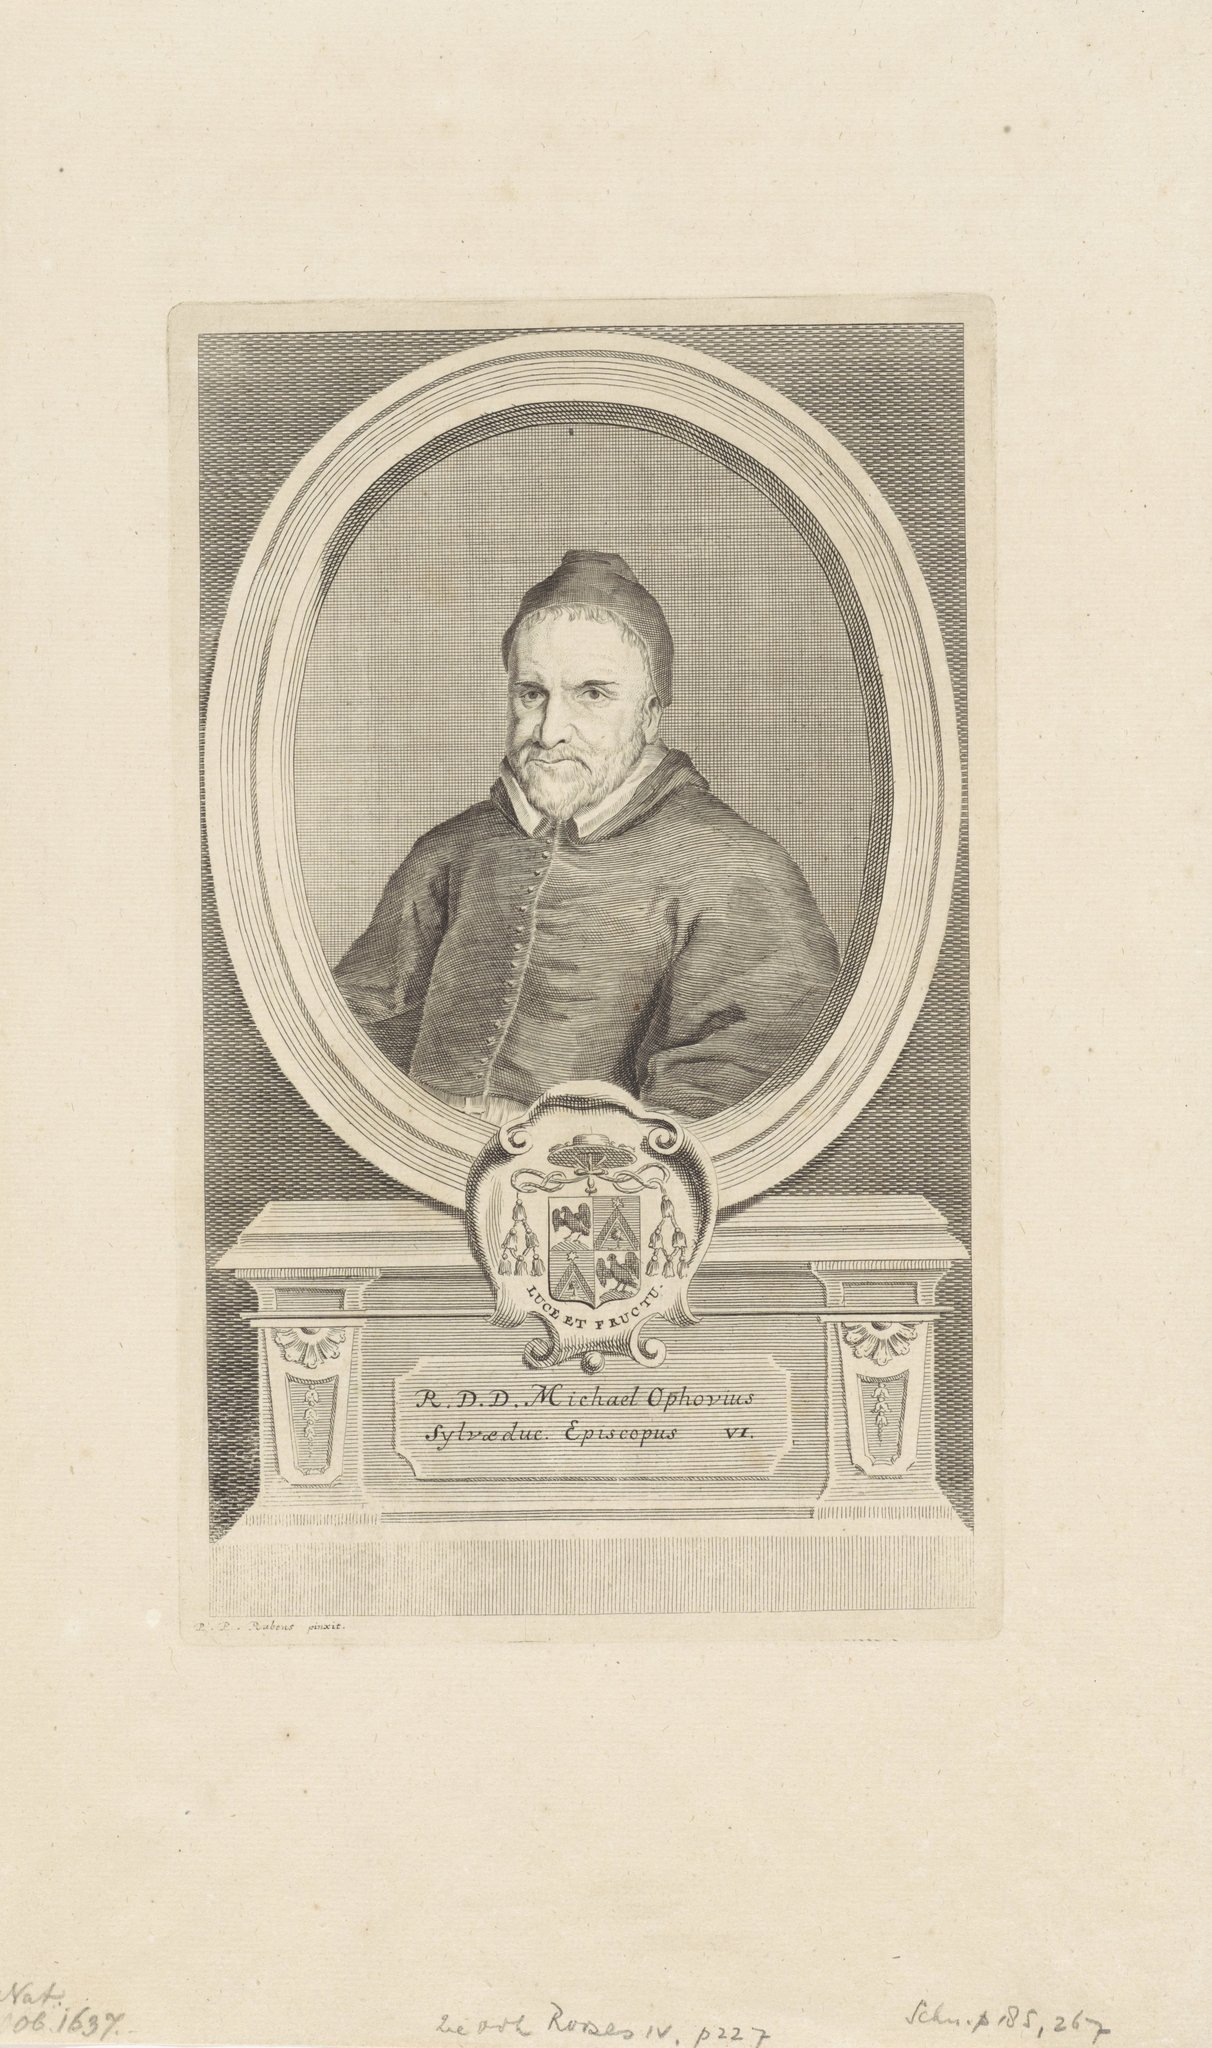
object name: print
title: Portret van Michael Ophovius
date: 1615-1690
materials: paper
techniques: engraving, etching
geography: antwerp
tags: michael ophovius, historical persons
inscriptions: collector's mark: Lugt 240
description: Buste van Michael Ophovius, bisschop van 's-Hertogenbosch, driekwart naar links. Rond het portret een ovale omlijsting met zijn wapen. Onder een tweeregelig onderschrift in het Latijn met de naam en functie van de geportretteerde.